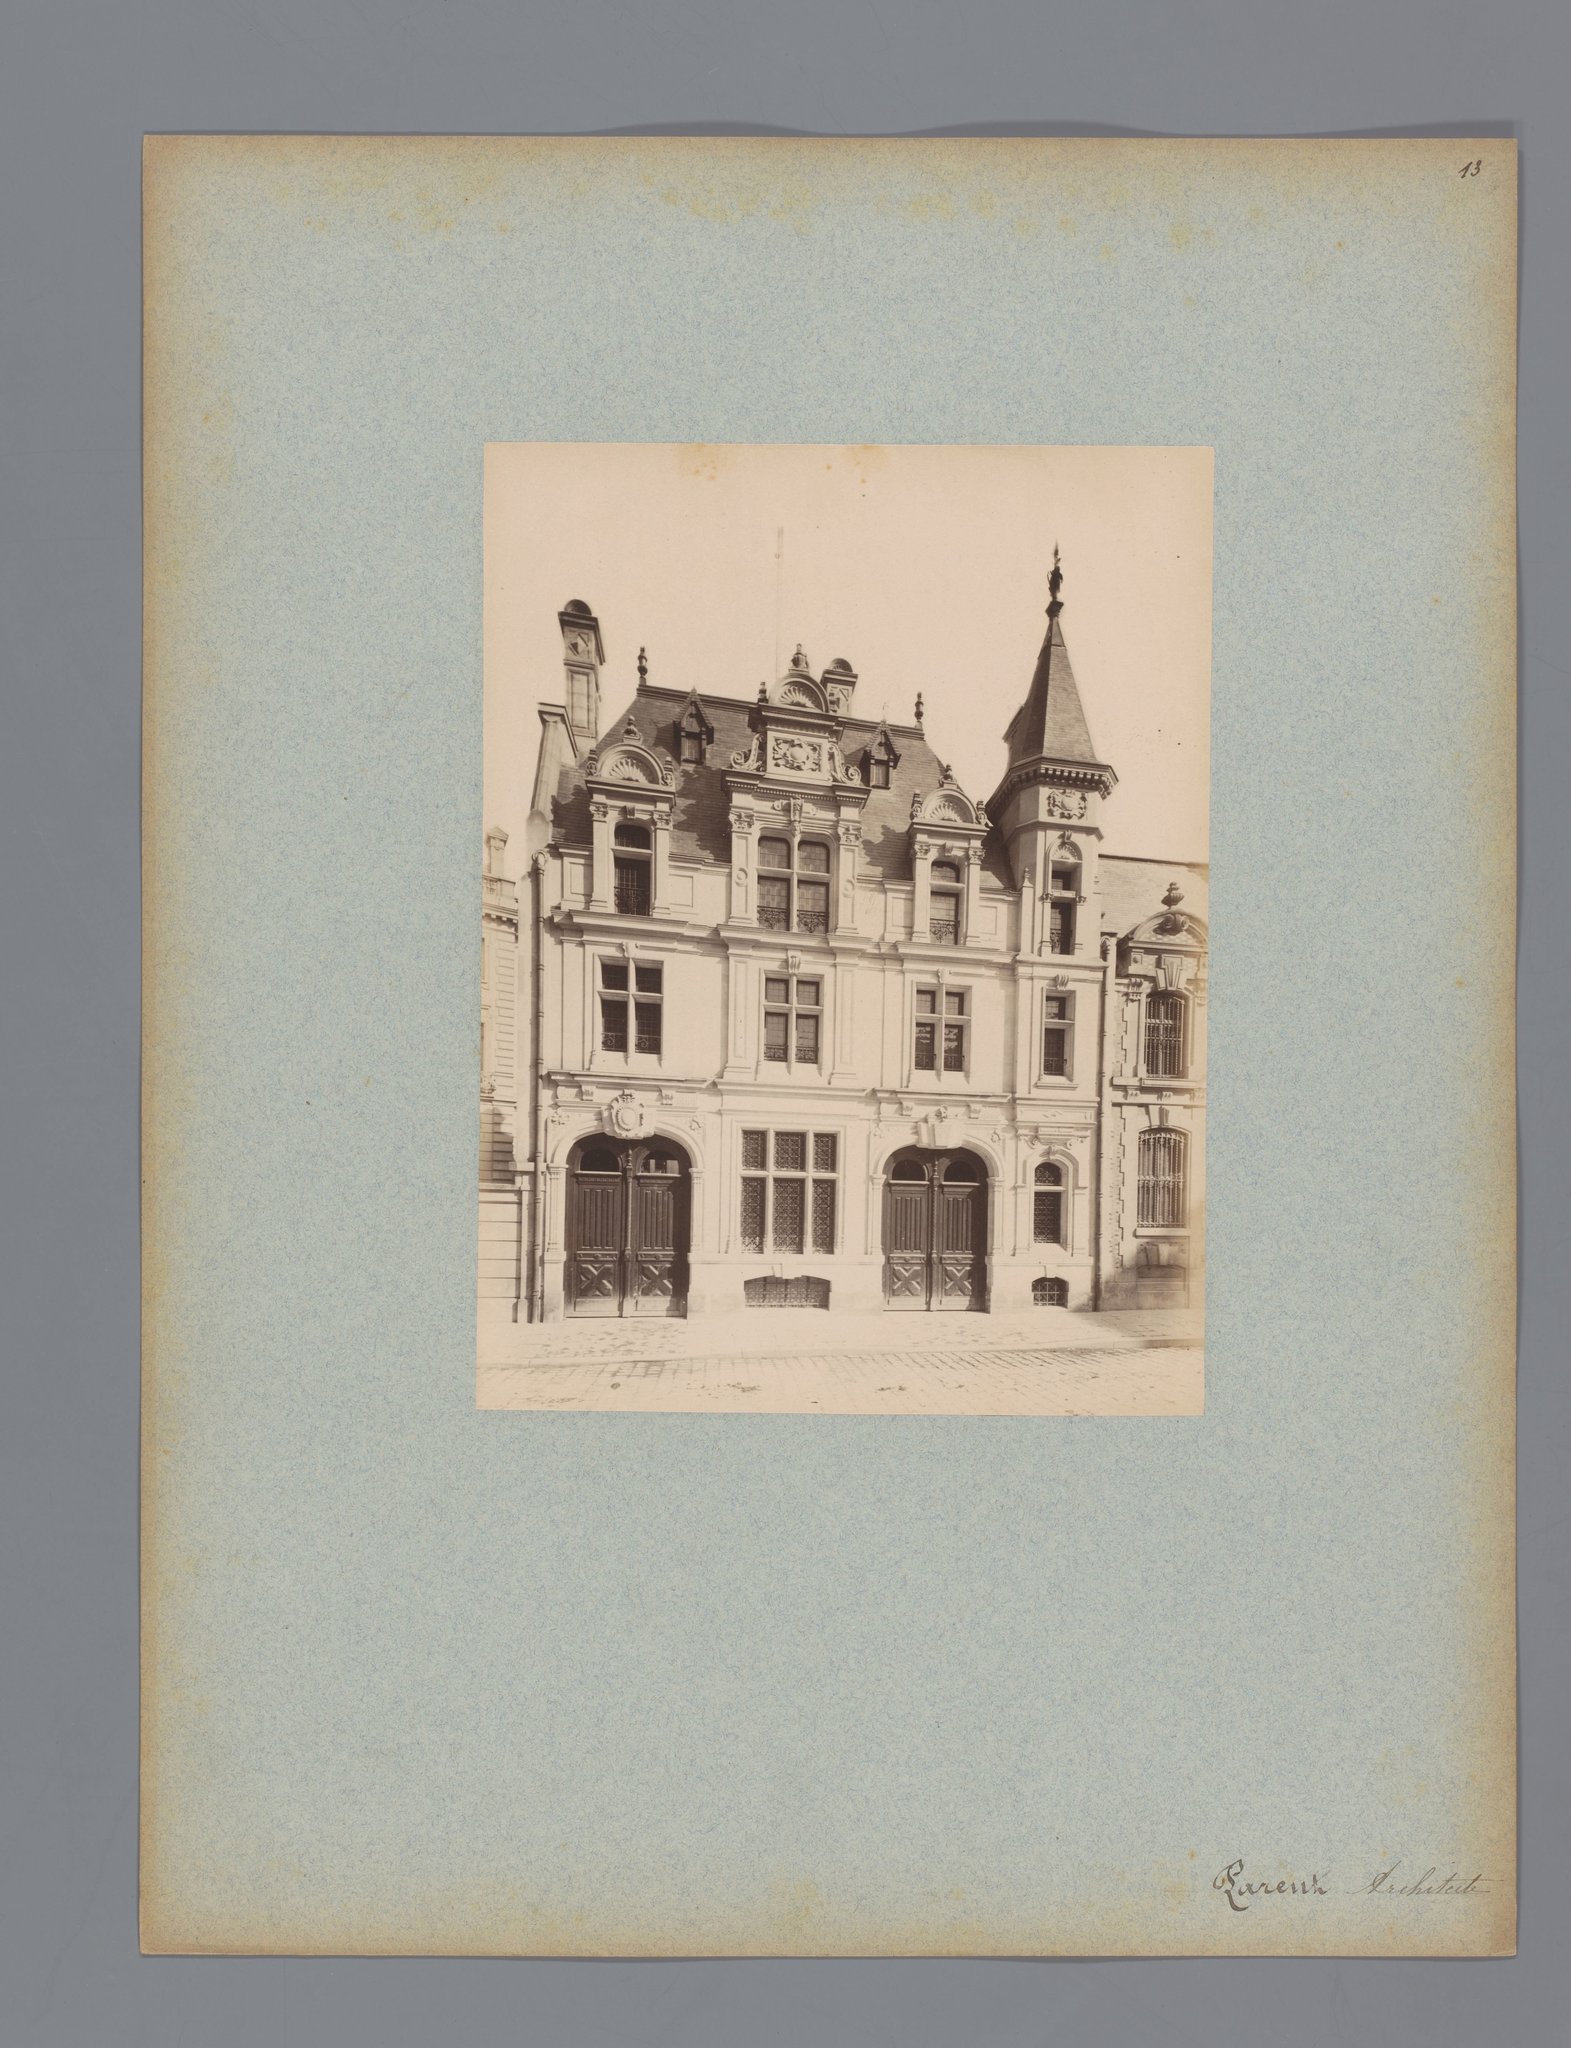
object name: photograph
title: Façade van een woonhuis in Parijs, ontworpen door Larent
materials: photographic support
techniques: albumen print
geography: paris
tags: urban housing, façade (of house or building), paris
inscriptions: name: ‘Parent Architecte’, number: ‘13’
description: Deze foto maakt deel uit van een omslag met 35 foto's en een titelblad.